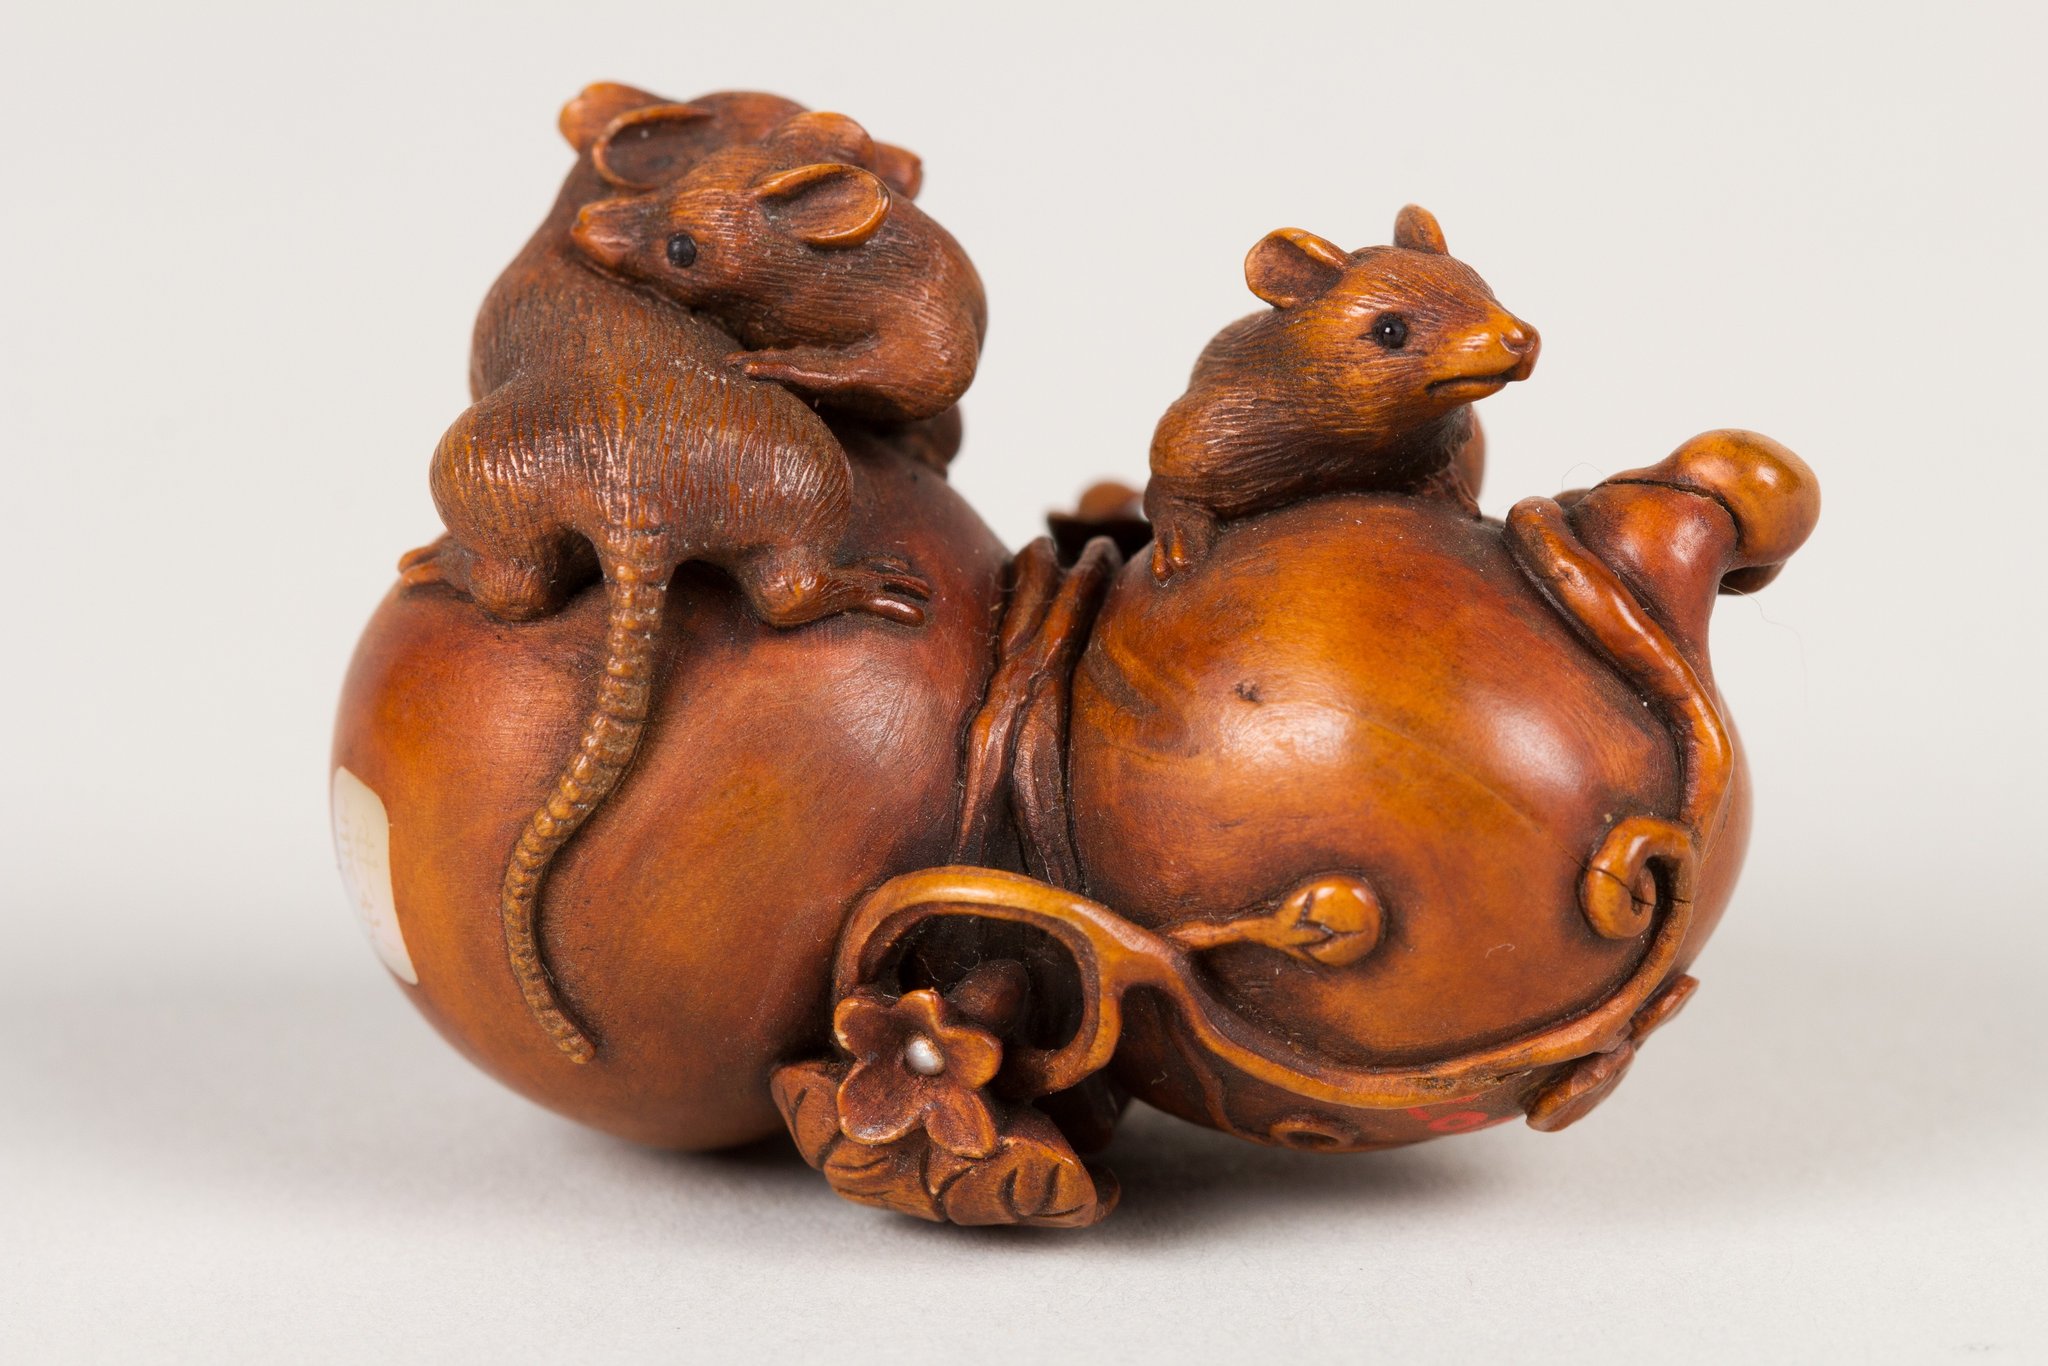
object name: netsuke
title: Netsuke of Gourd and Mice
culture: japanese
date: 1801-1900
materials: wood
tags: mice